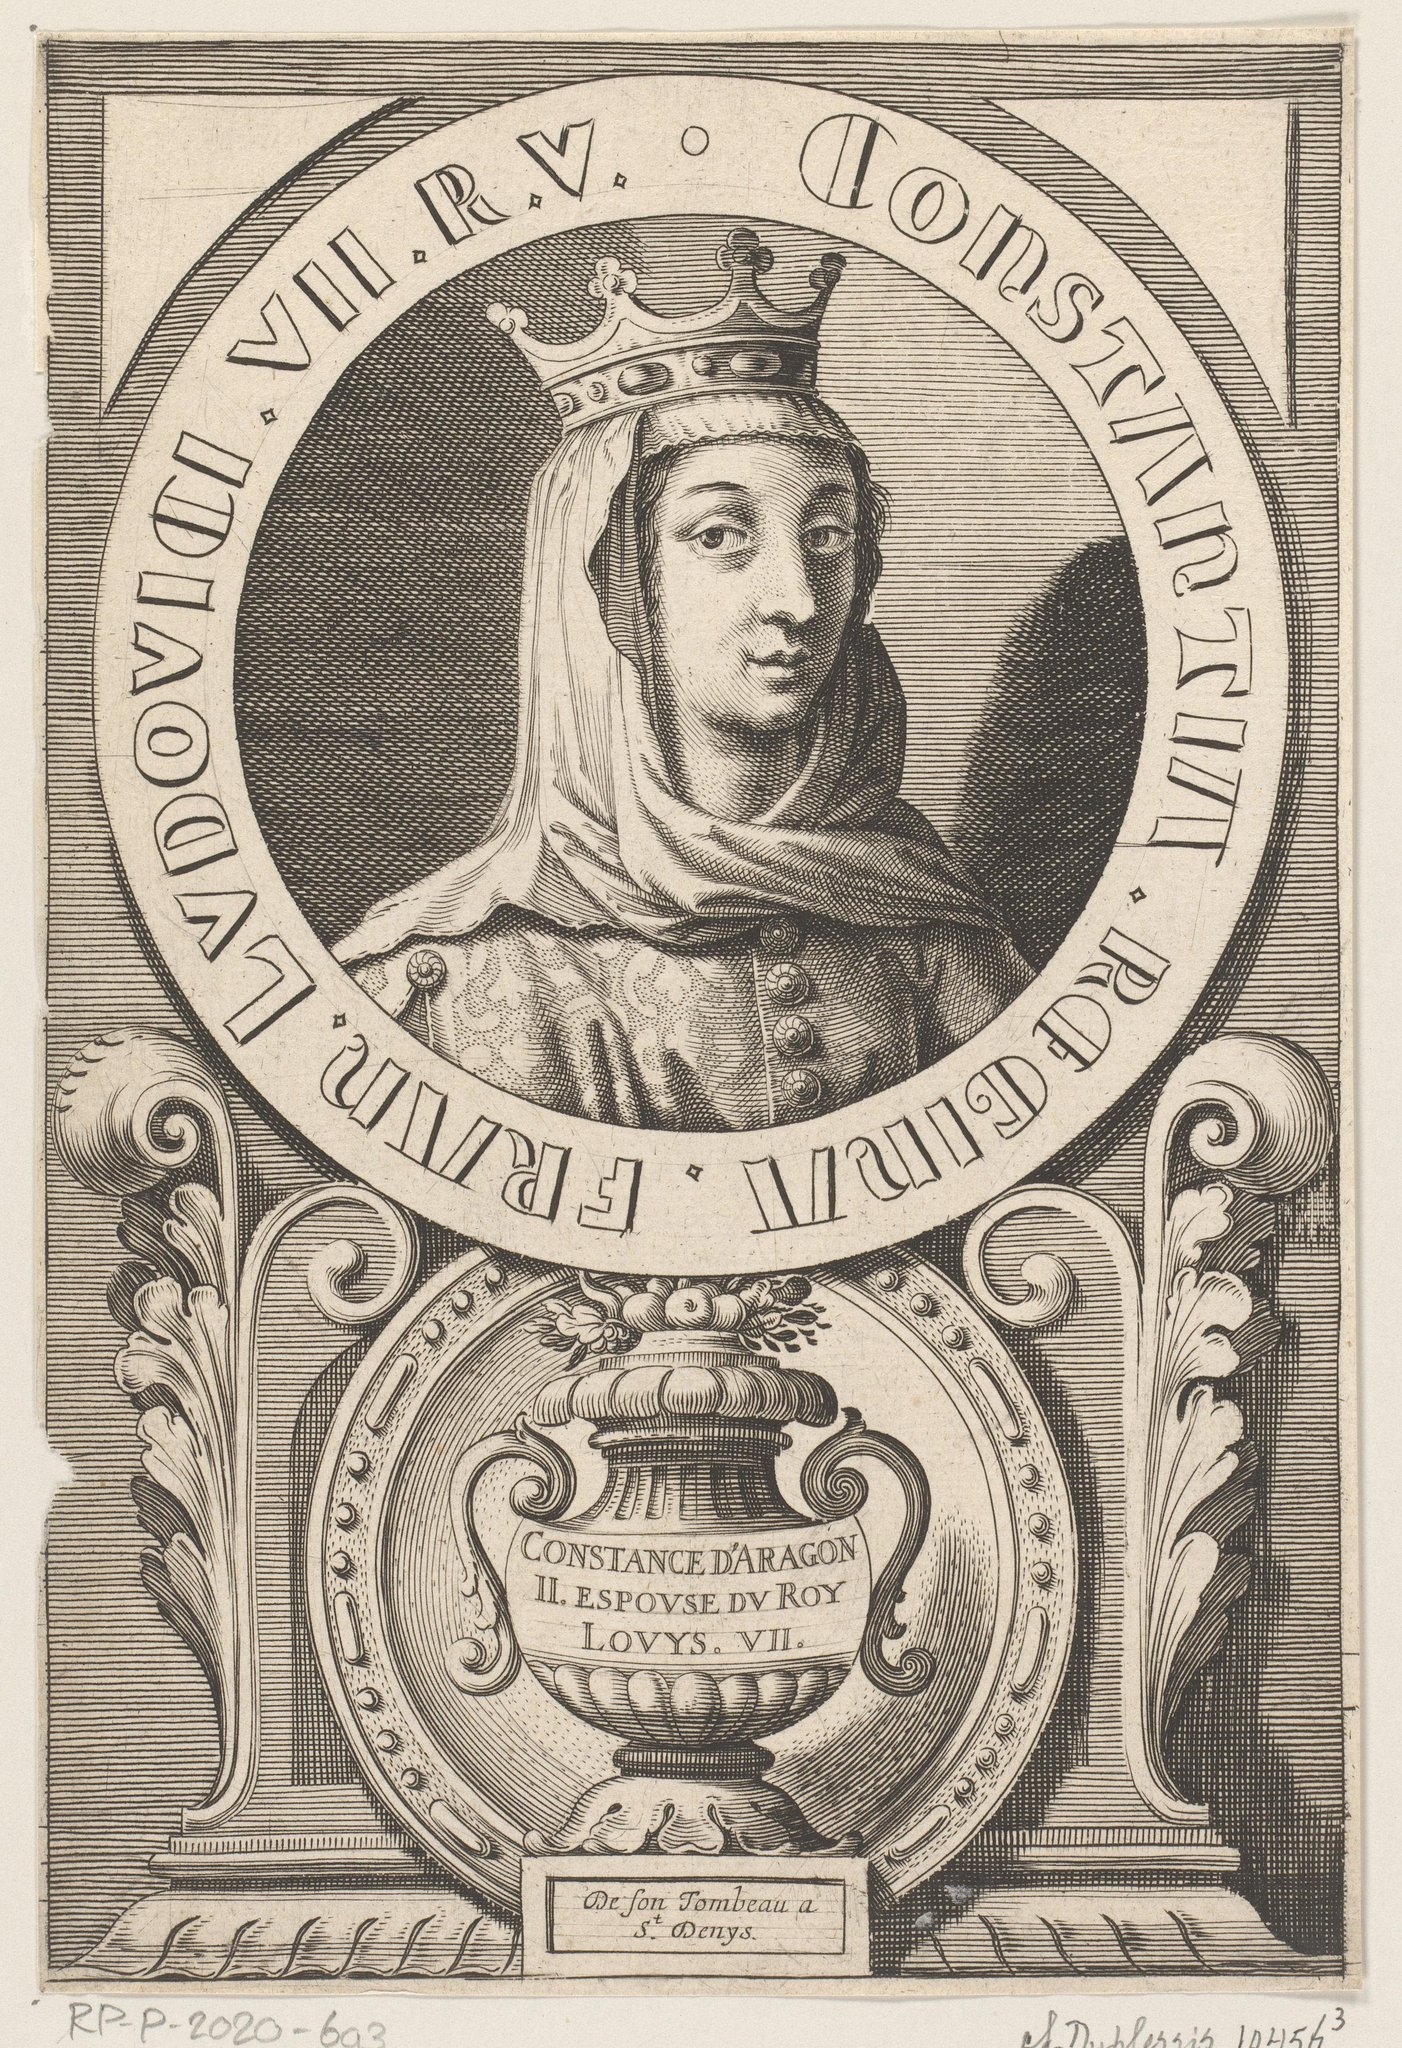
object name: print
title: Constance d'Aragon II. Espouse du roy Louys. VII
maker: jacques de bie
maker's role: print maker, publisher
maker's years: 1581-1647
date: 1634-1685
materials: paper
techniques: engraving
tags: paris, historical persons - bb - woman, queen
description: Prent waarschijnlijk voor het eerst verschenen in: Bie, Jacques de. Les vrais portraits des rois de France (...). Parijs: Jacques de Bie en Pierre Rocolet, 1634. Prent ook gebruikt in latere publicaties, in ieder geval tot in 1685.